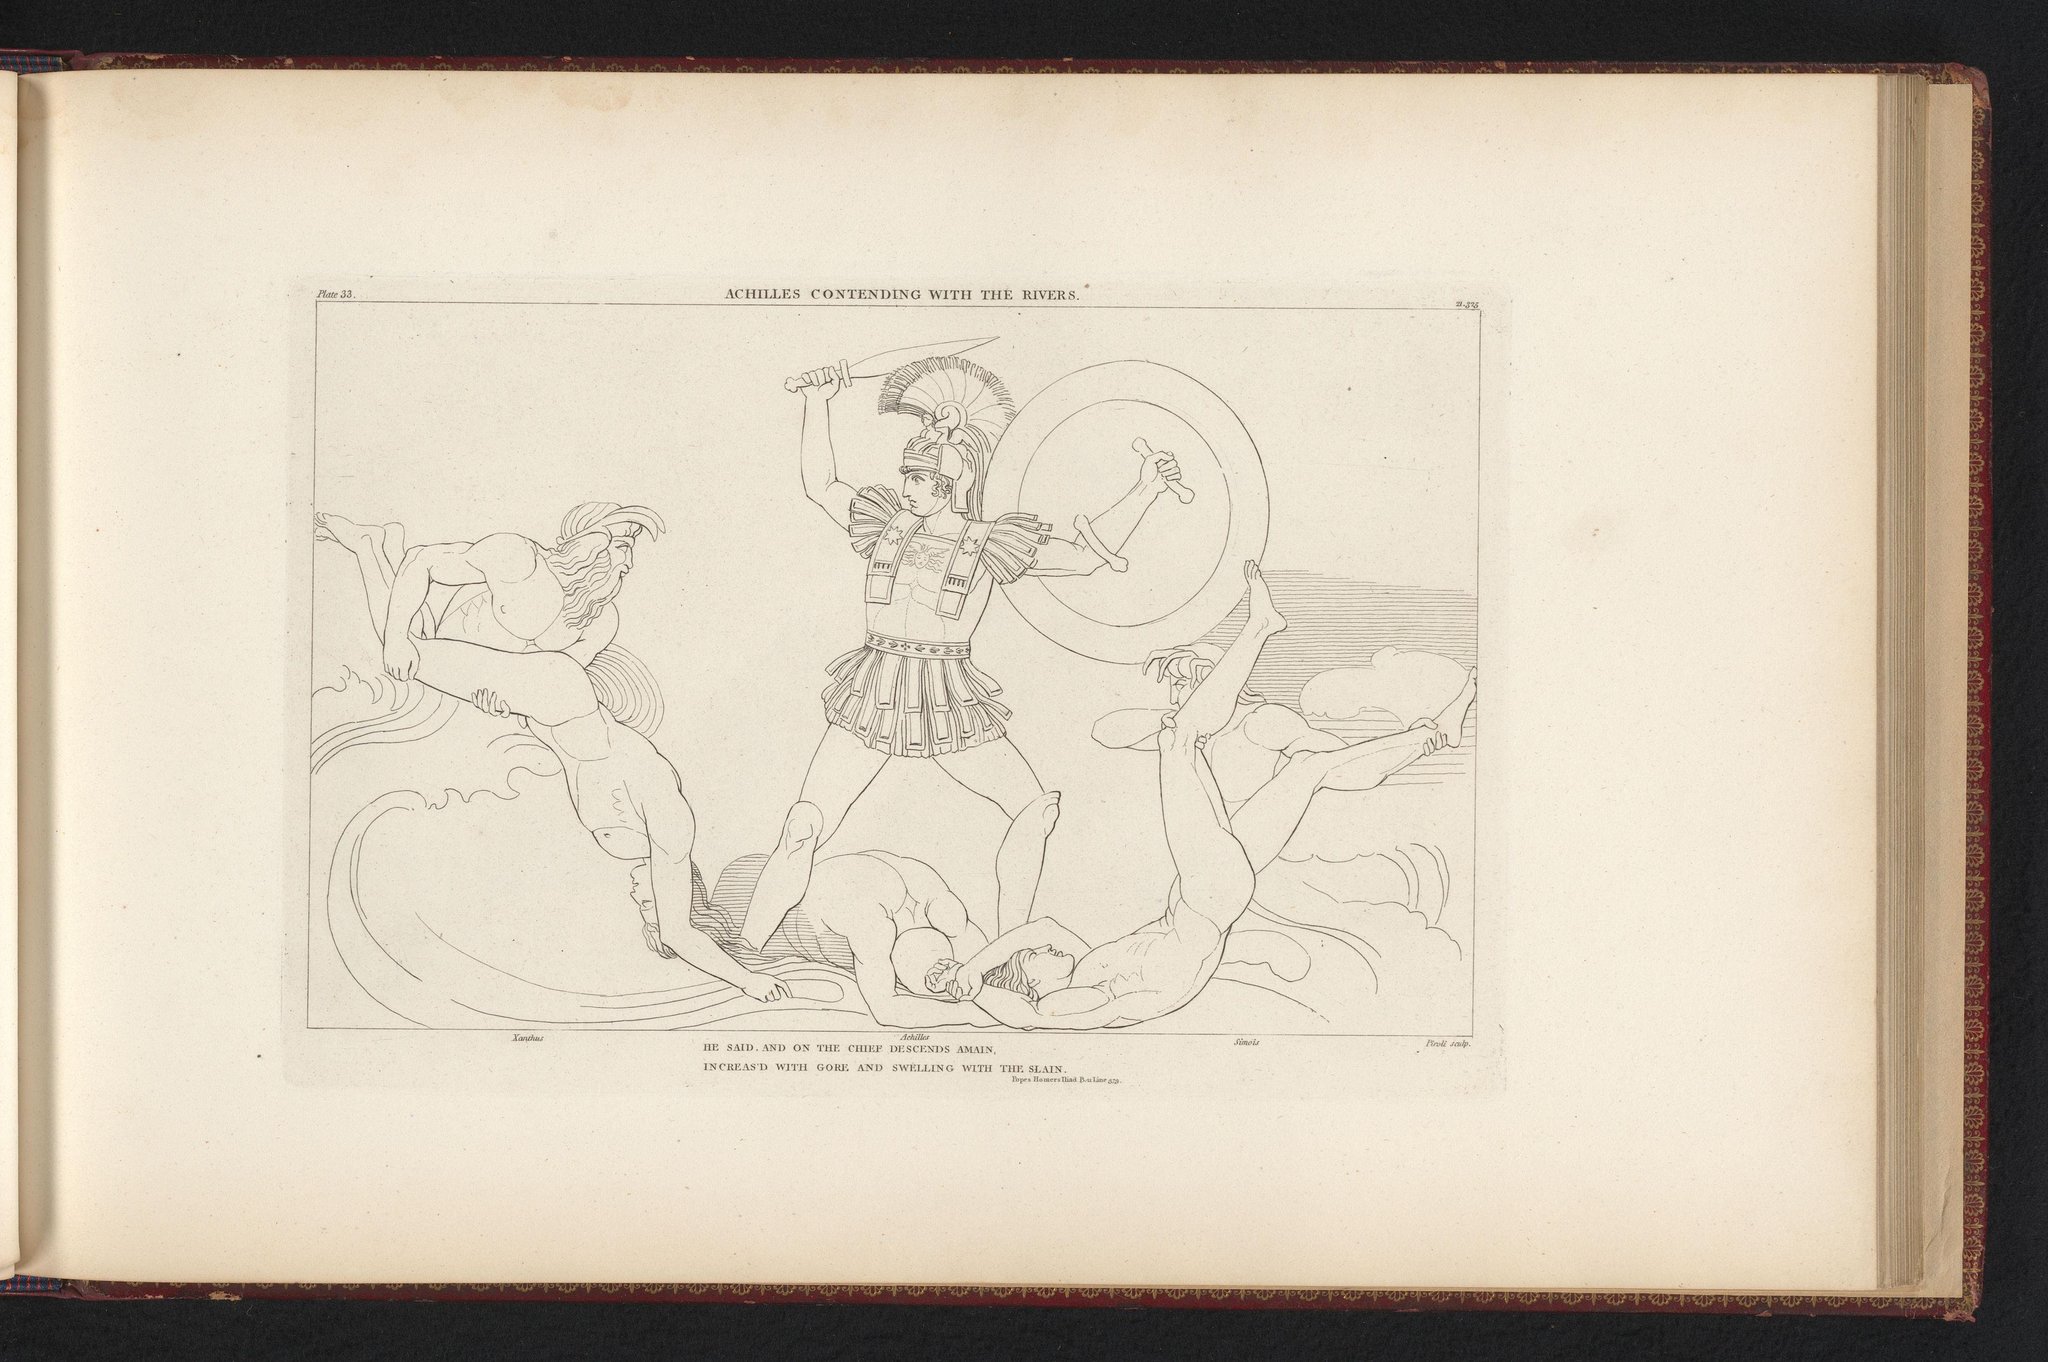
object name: print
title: Ilias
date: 1805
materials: paper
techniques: etching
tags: achilles fights the river-gods scamander and simois; achilles is assisted by vulcan, who dries up the waters with scorching flames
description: Prent maakt onderdeel uit van een serie met 39 prenten over de Ilias, geschreven door Homerus.